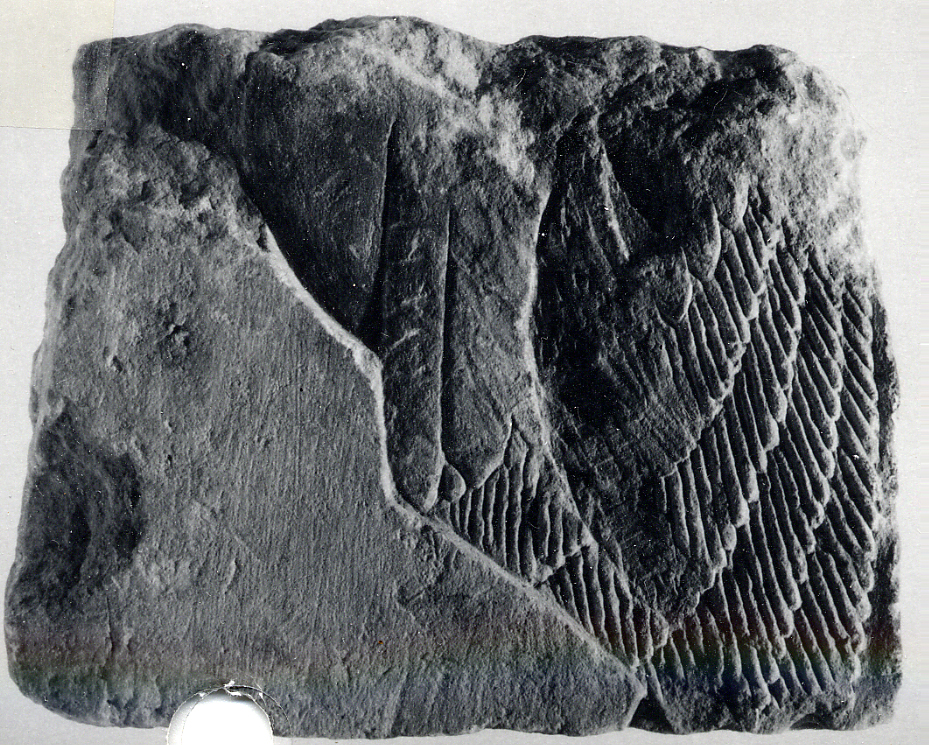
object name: talatat, princess's head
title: Relief with a princess's head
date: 1353-1336 BCE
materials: limestone, paint